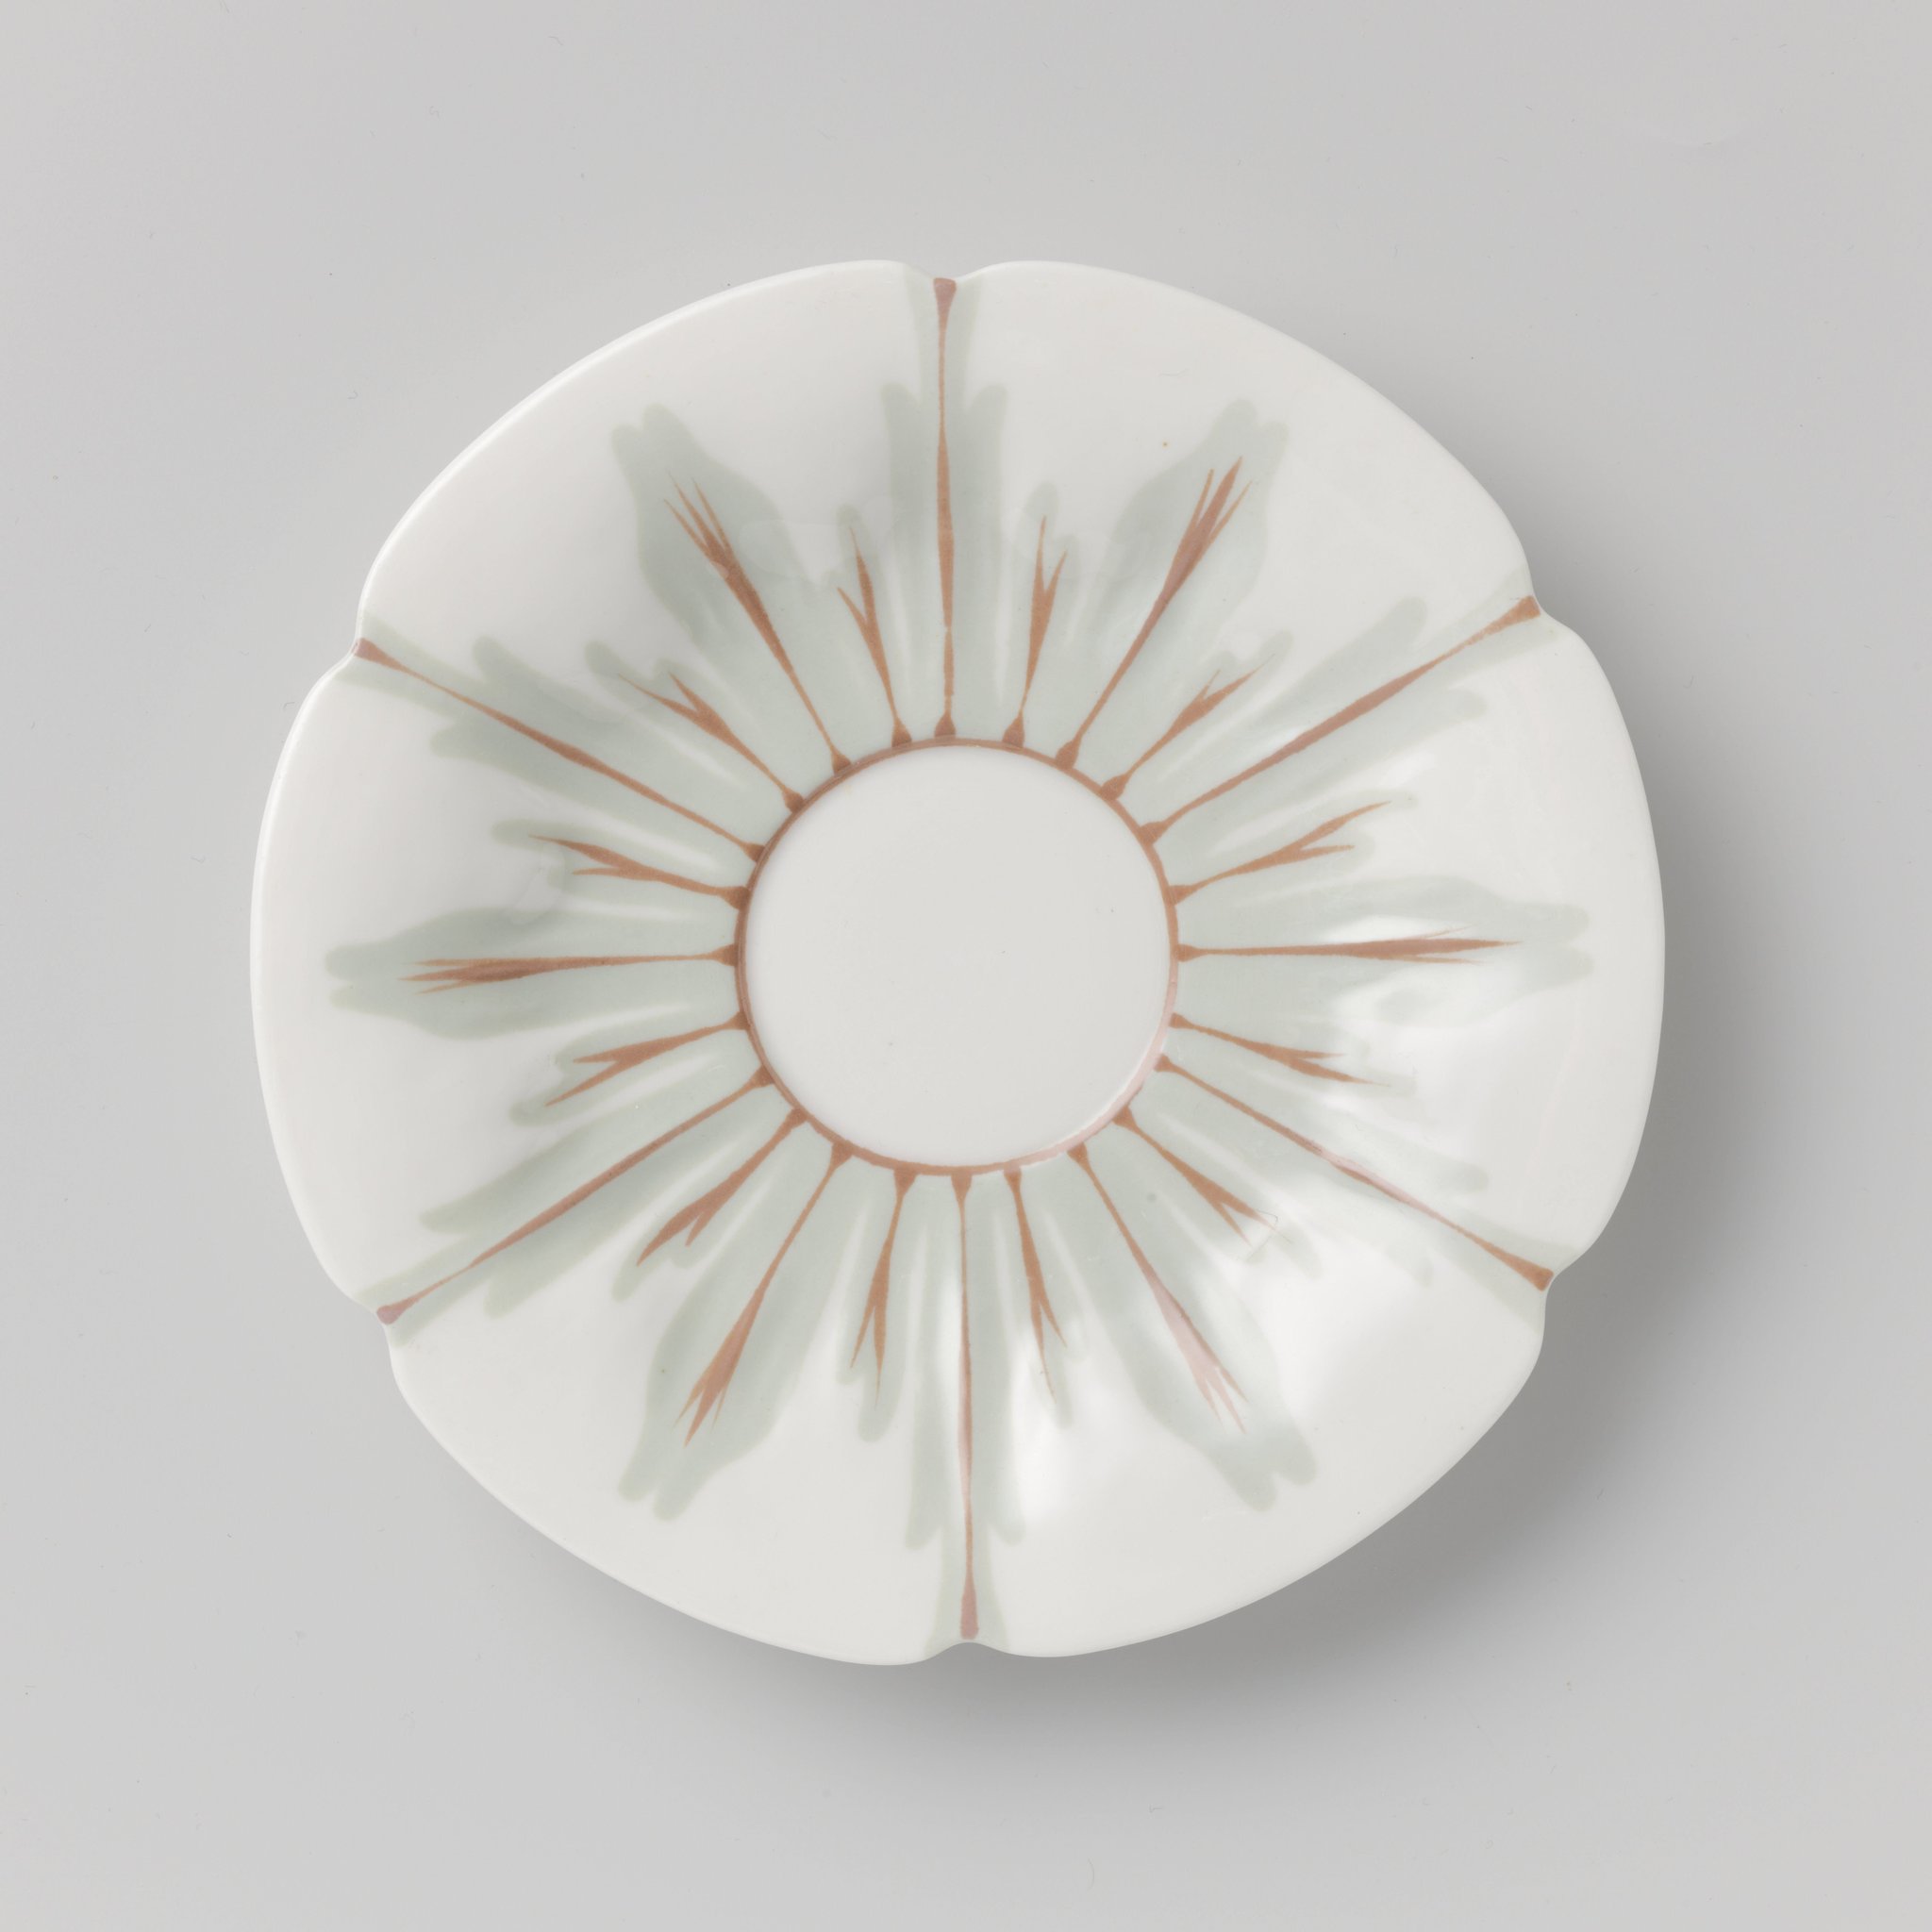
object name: platter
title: Schotel, beschilderd met het Krokus-decor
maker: konrad hentschel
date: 1896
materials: porcelain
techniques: painted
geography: meissen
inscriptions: model number: ‘71’, factory mark, mark: ‘71’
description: Parts of a coffee service. Porcelain. Meissen, Königlich Sächsische Porzellanmanufaktur, 1896, designed by Julius Konrad Hentschel.